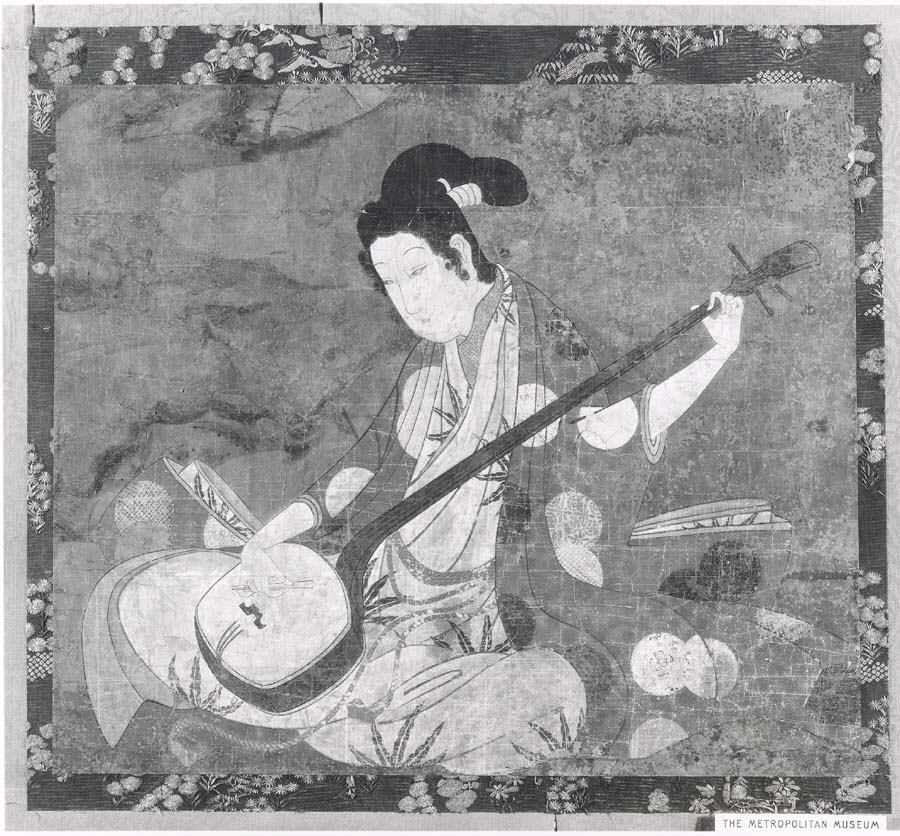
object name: hanging scroll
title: Beauty Playing a Shamisen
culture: japanese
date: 1626-1650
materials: ink, paper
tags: musical instruments,women